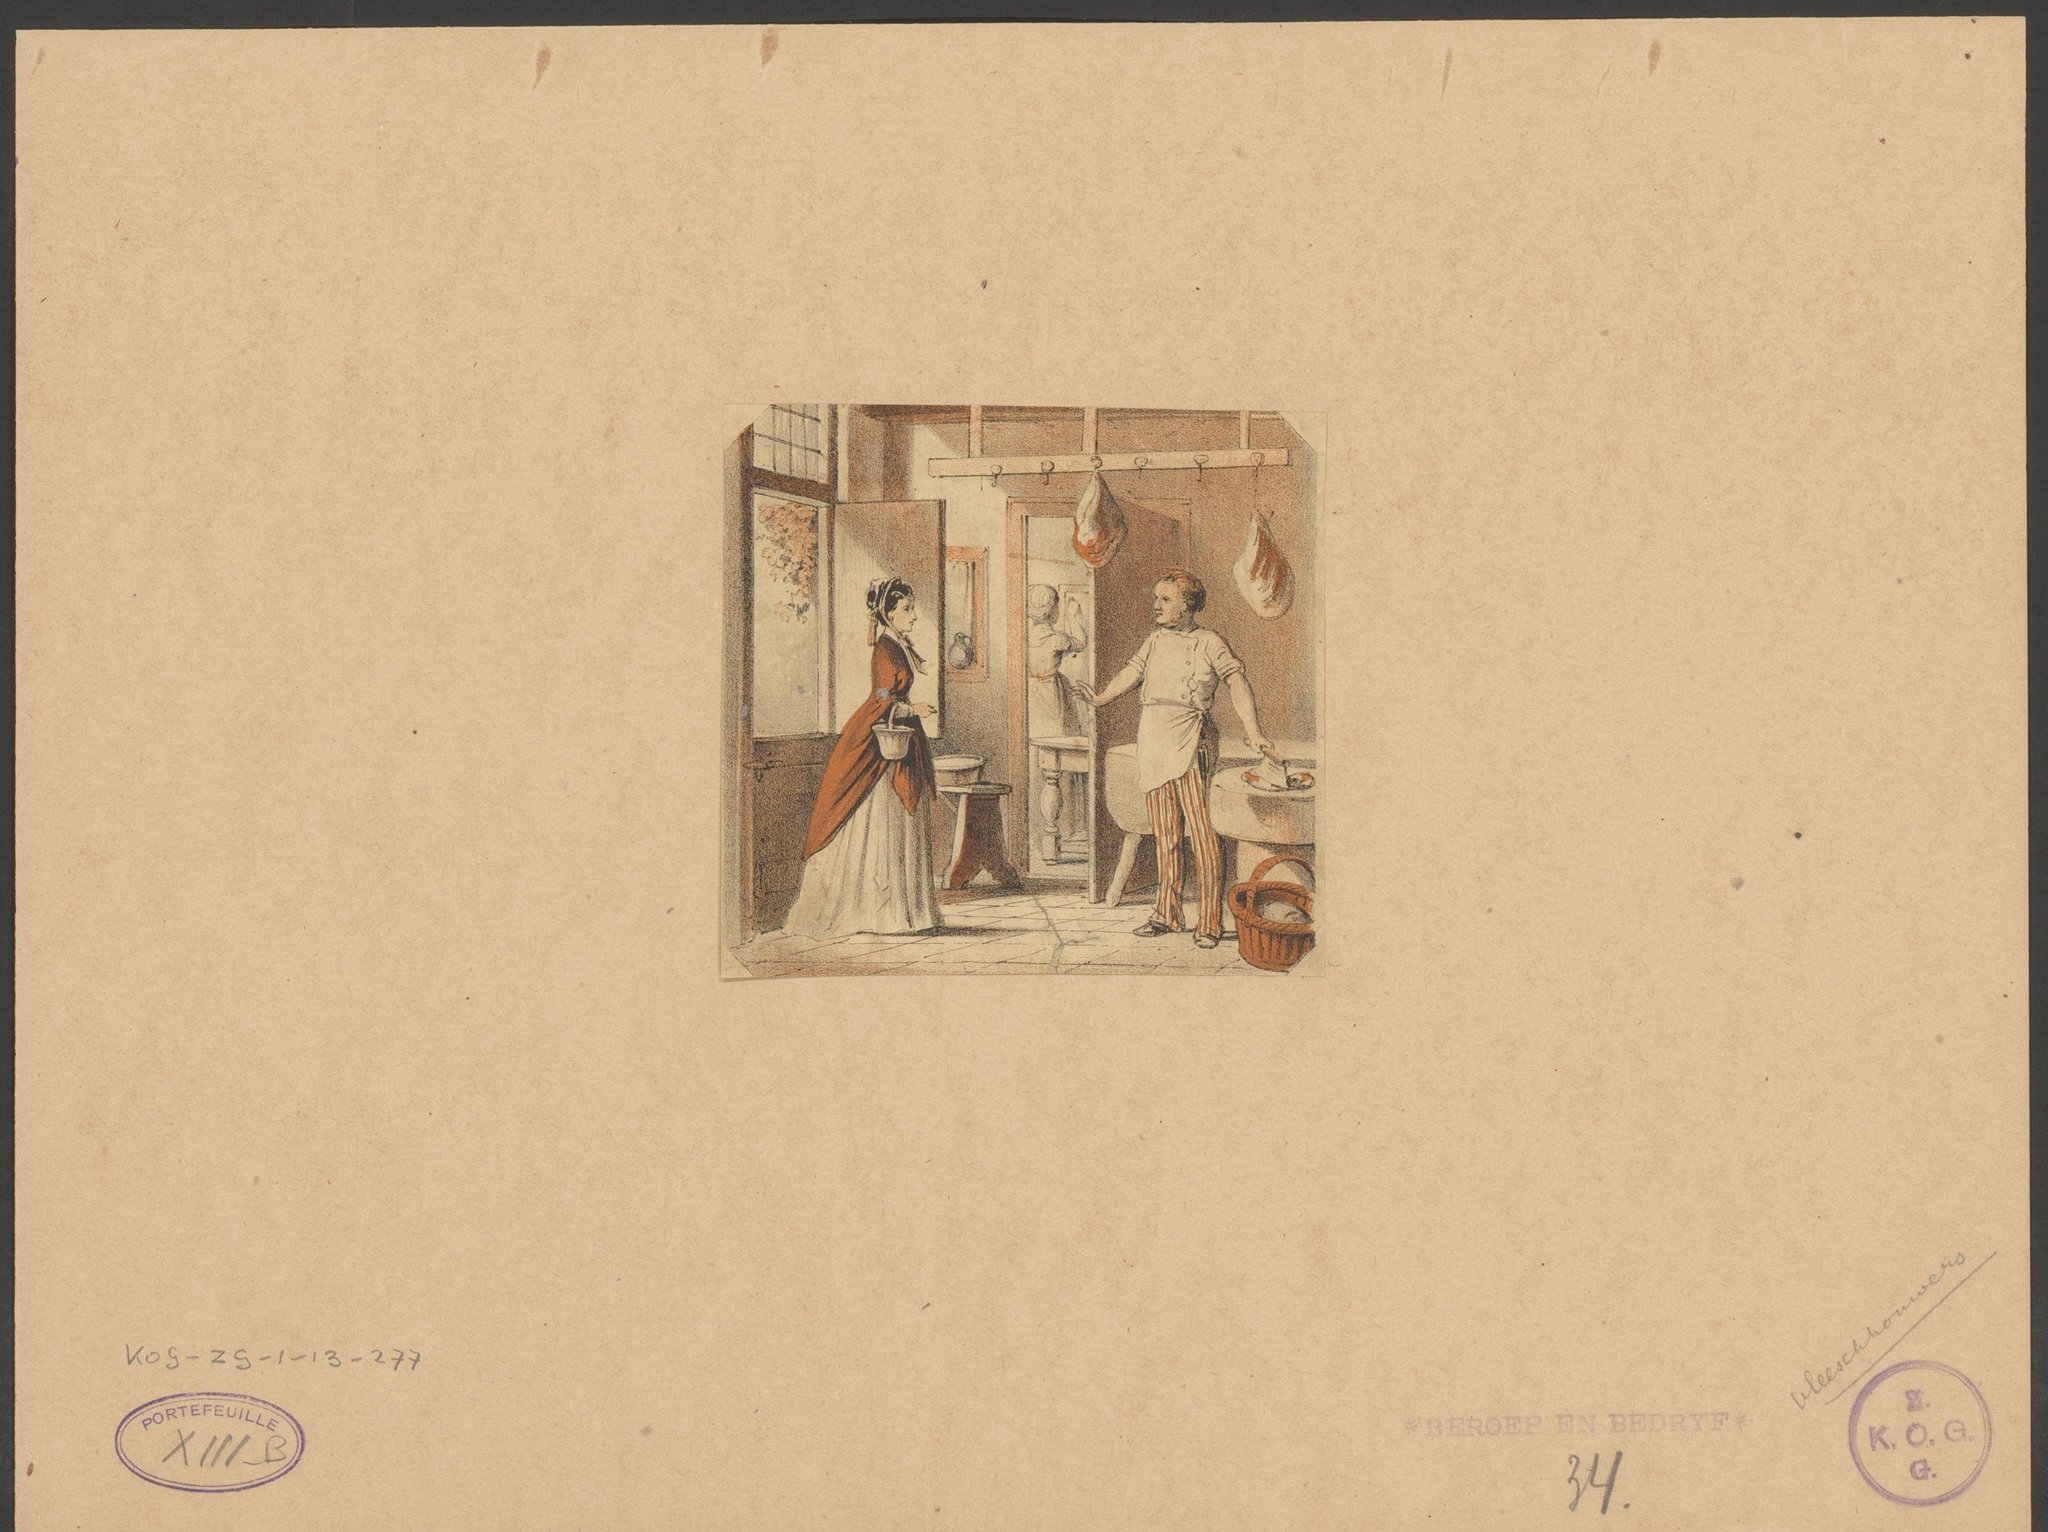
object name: print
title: Vrouw bij de slager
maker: Anonymous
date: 1800-1899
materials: paper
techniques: lithograph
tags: butcher, slaughterman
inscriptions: stamp, stamp, collector's mark: Lugt 1641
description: Onderwerpsrubrieken binnen de Atlas Zeden en Gewoonten: Handel, Nijverheid en Verkeer, Beroep en bedrijf, Mannelijk, Eet- en drinkwaren.